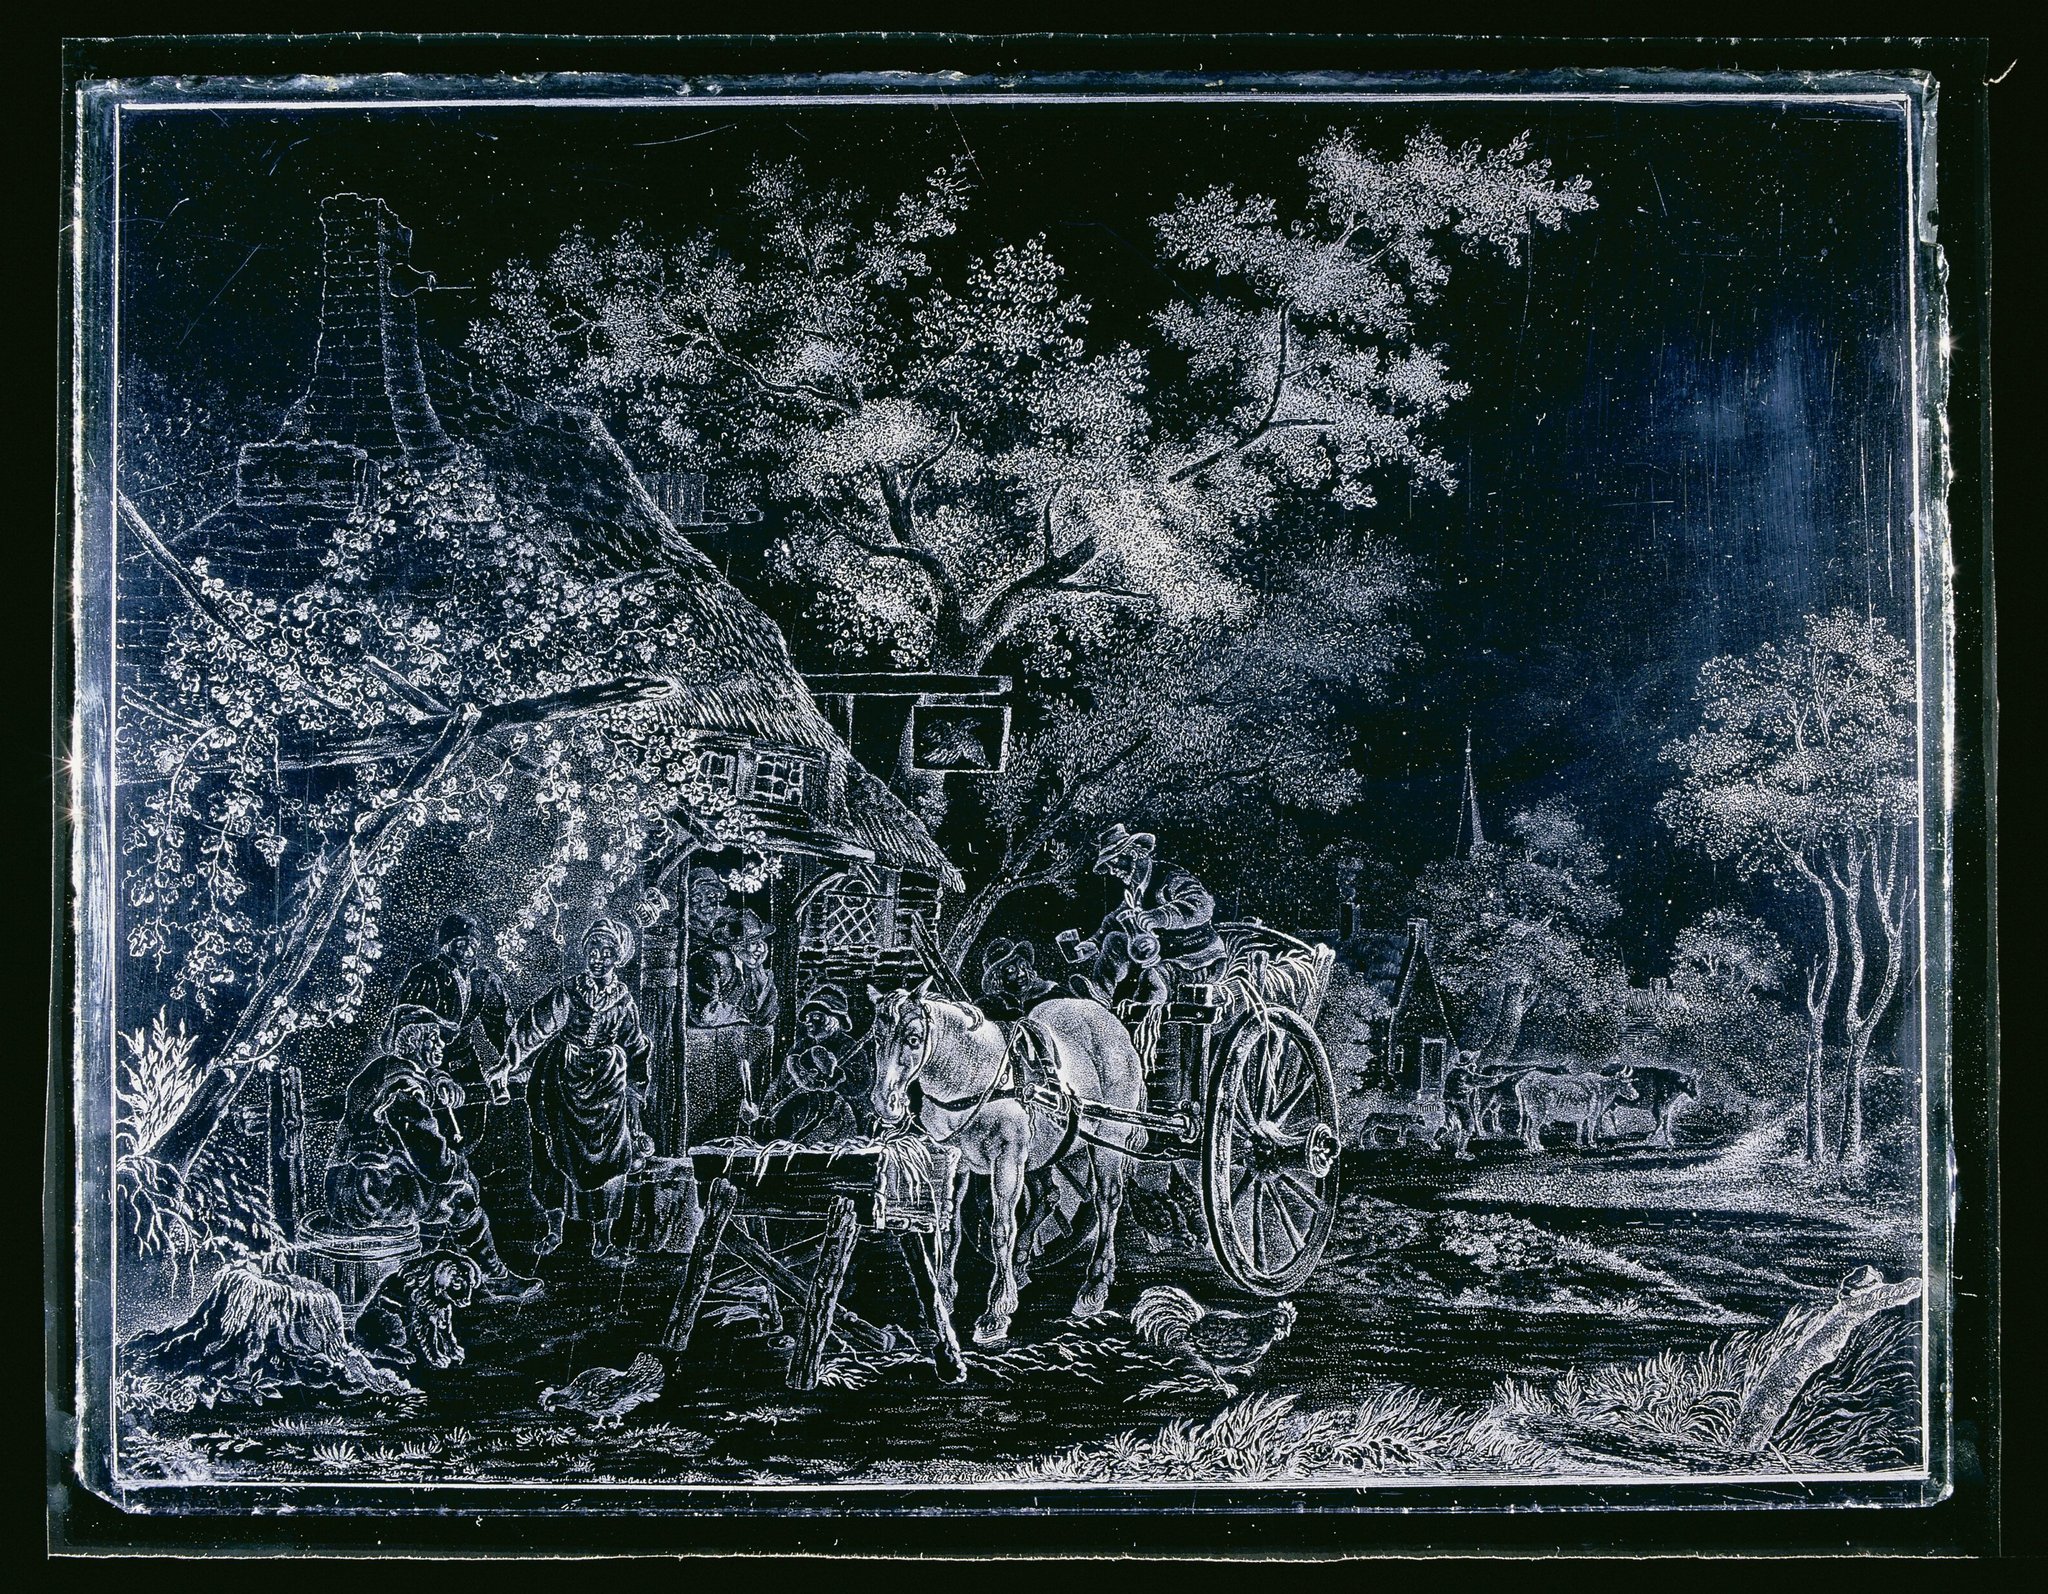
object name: light window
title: Ruit met paard en wagen en enkele figuren voor een herberg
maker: andries melort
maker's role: glasetser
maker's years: 1778-1849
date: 1839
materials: glass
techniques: diamond point engraving, engraving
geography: netherlands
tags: william ii of the netherlands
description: Panel. Glass, diamond-point and stipple engraving. Breda, 1839, by Andries Melort.